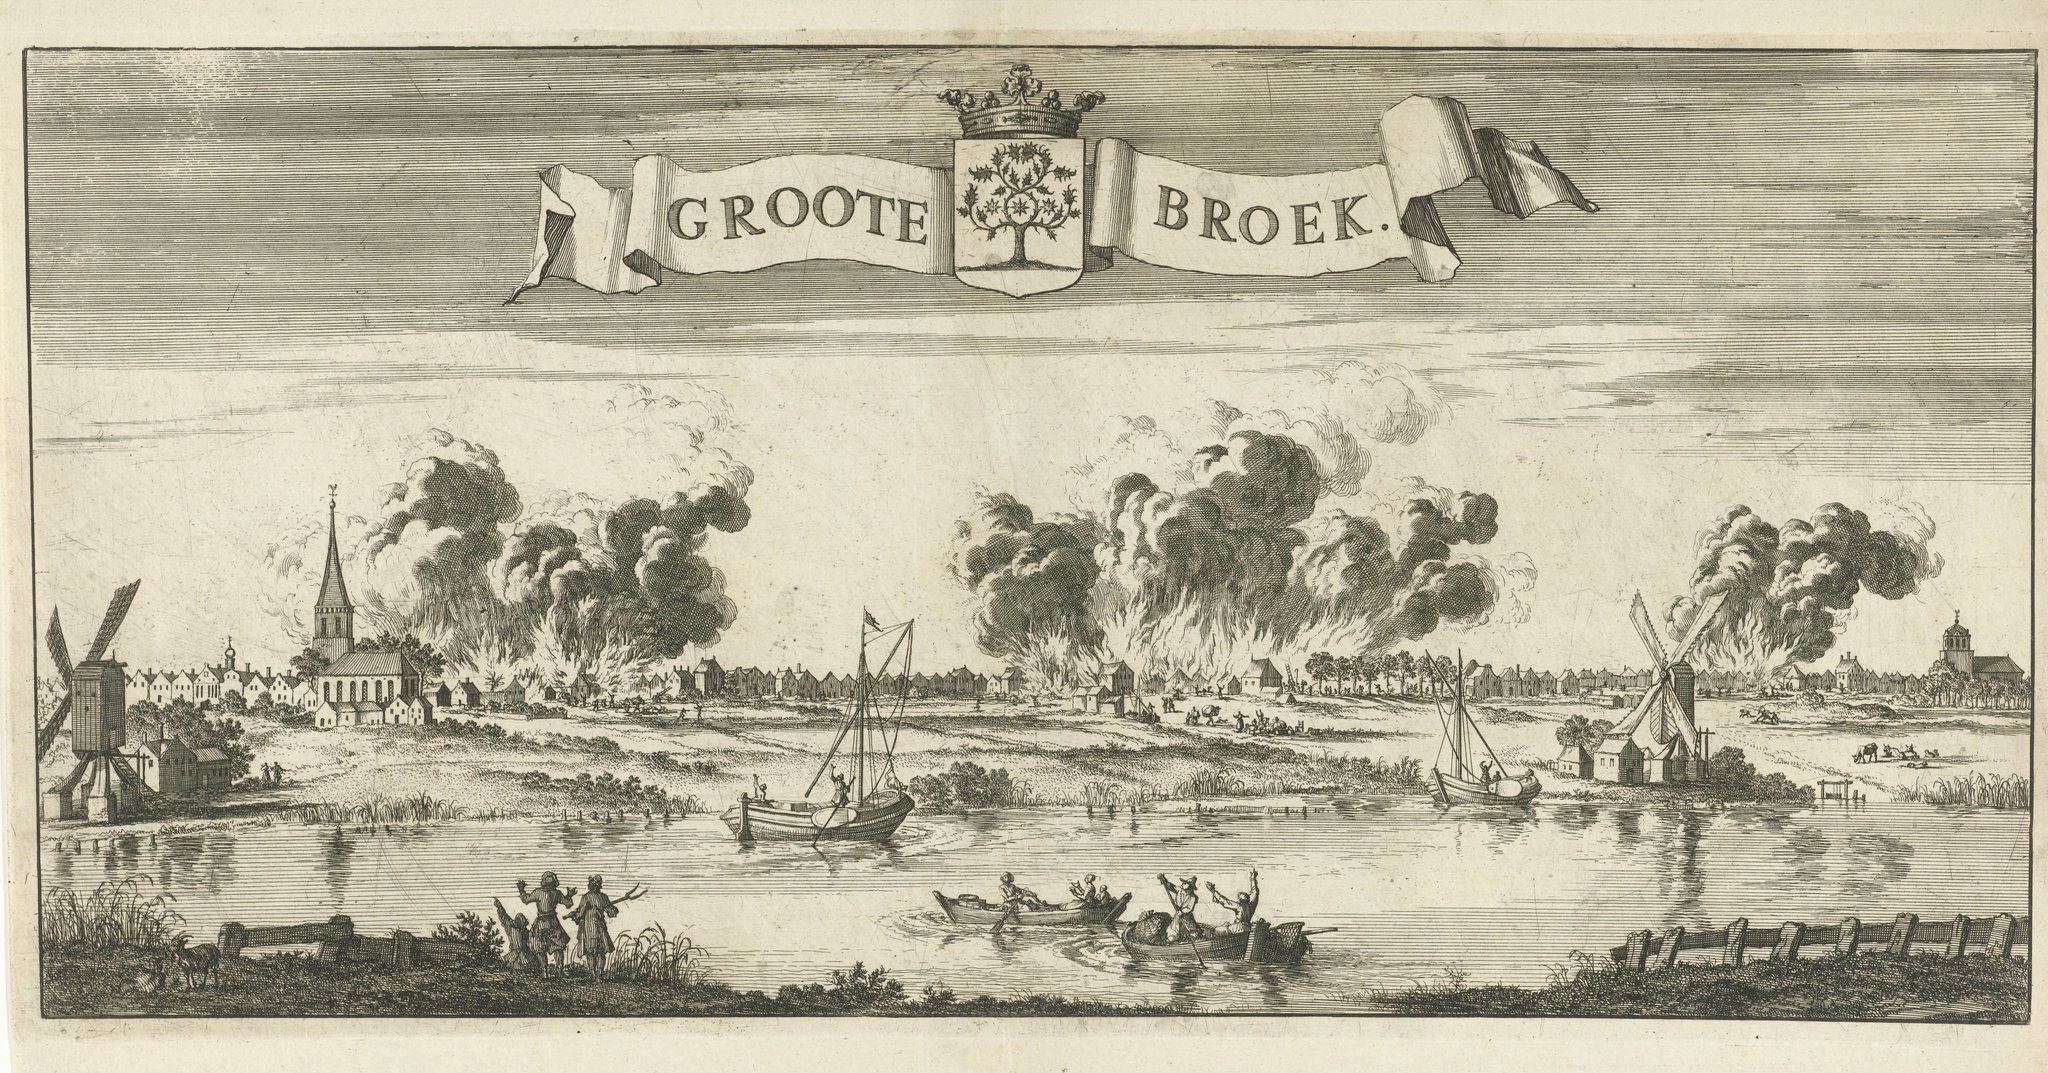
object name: print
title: Groote Broek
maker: jan luyken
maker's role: draughtsman, print maker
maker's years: 1649-1712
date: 1694-1696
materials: paper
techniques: etching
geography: amsterdam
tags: fire-fighting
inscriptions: collector's mark: Lugt 2228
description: De plaat is ook gebruikt als onderdeel van de loterijprent voor de loterij gehouden voor de slachtoffers in 1694-1695.